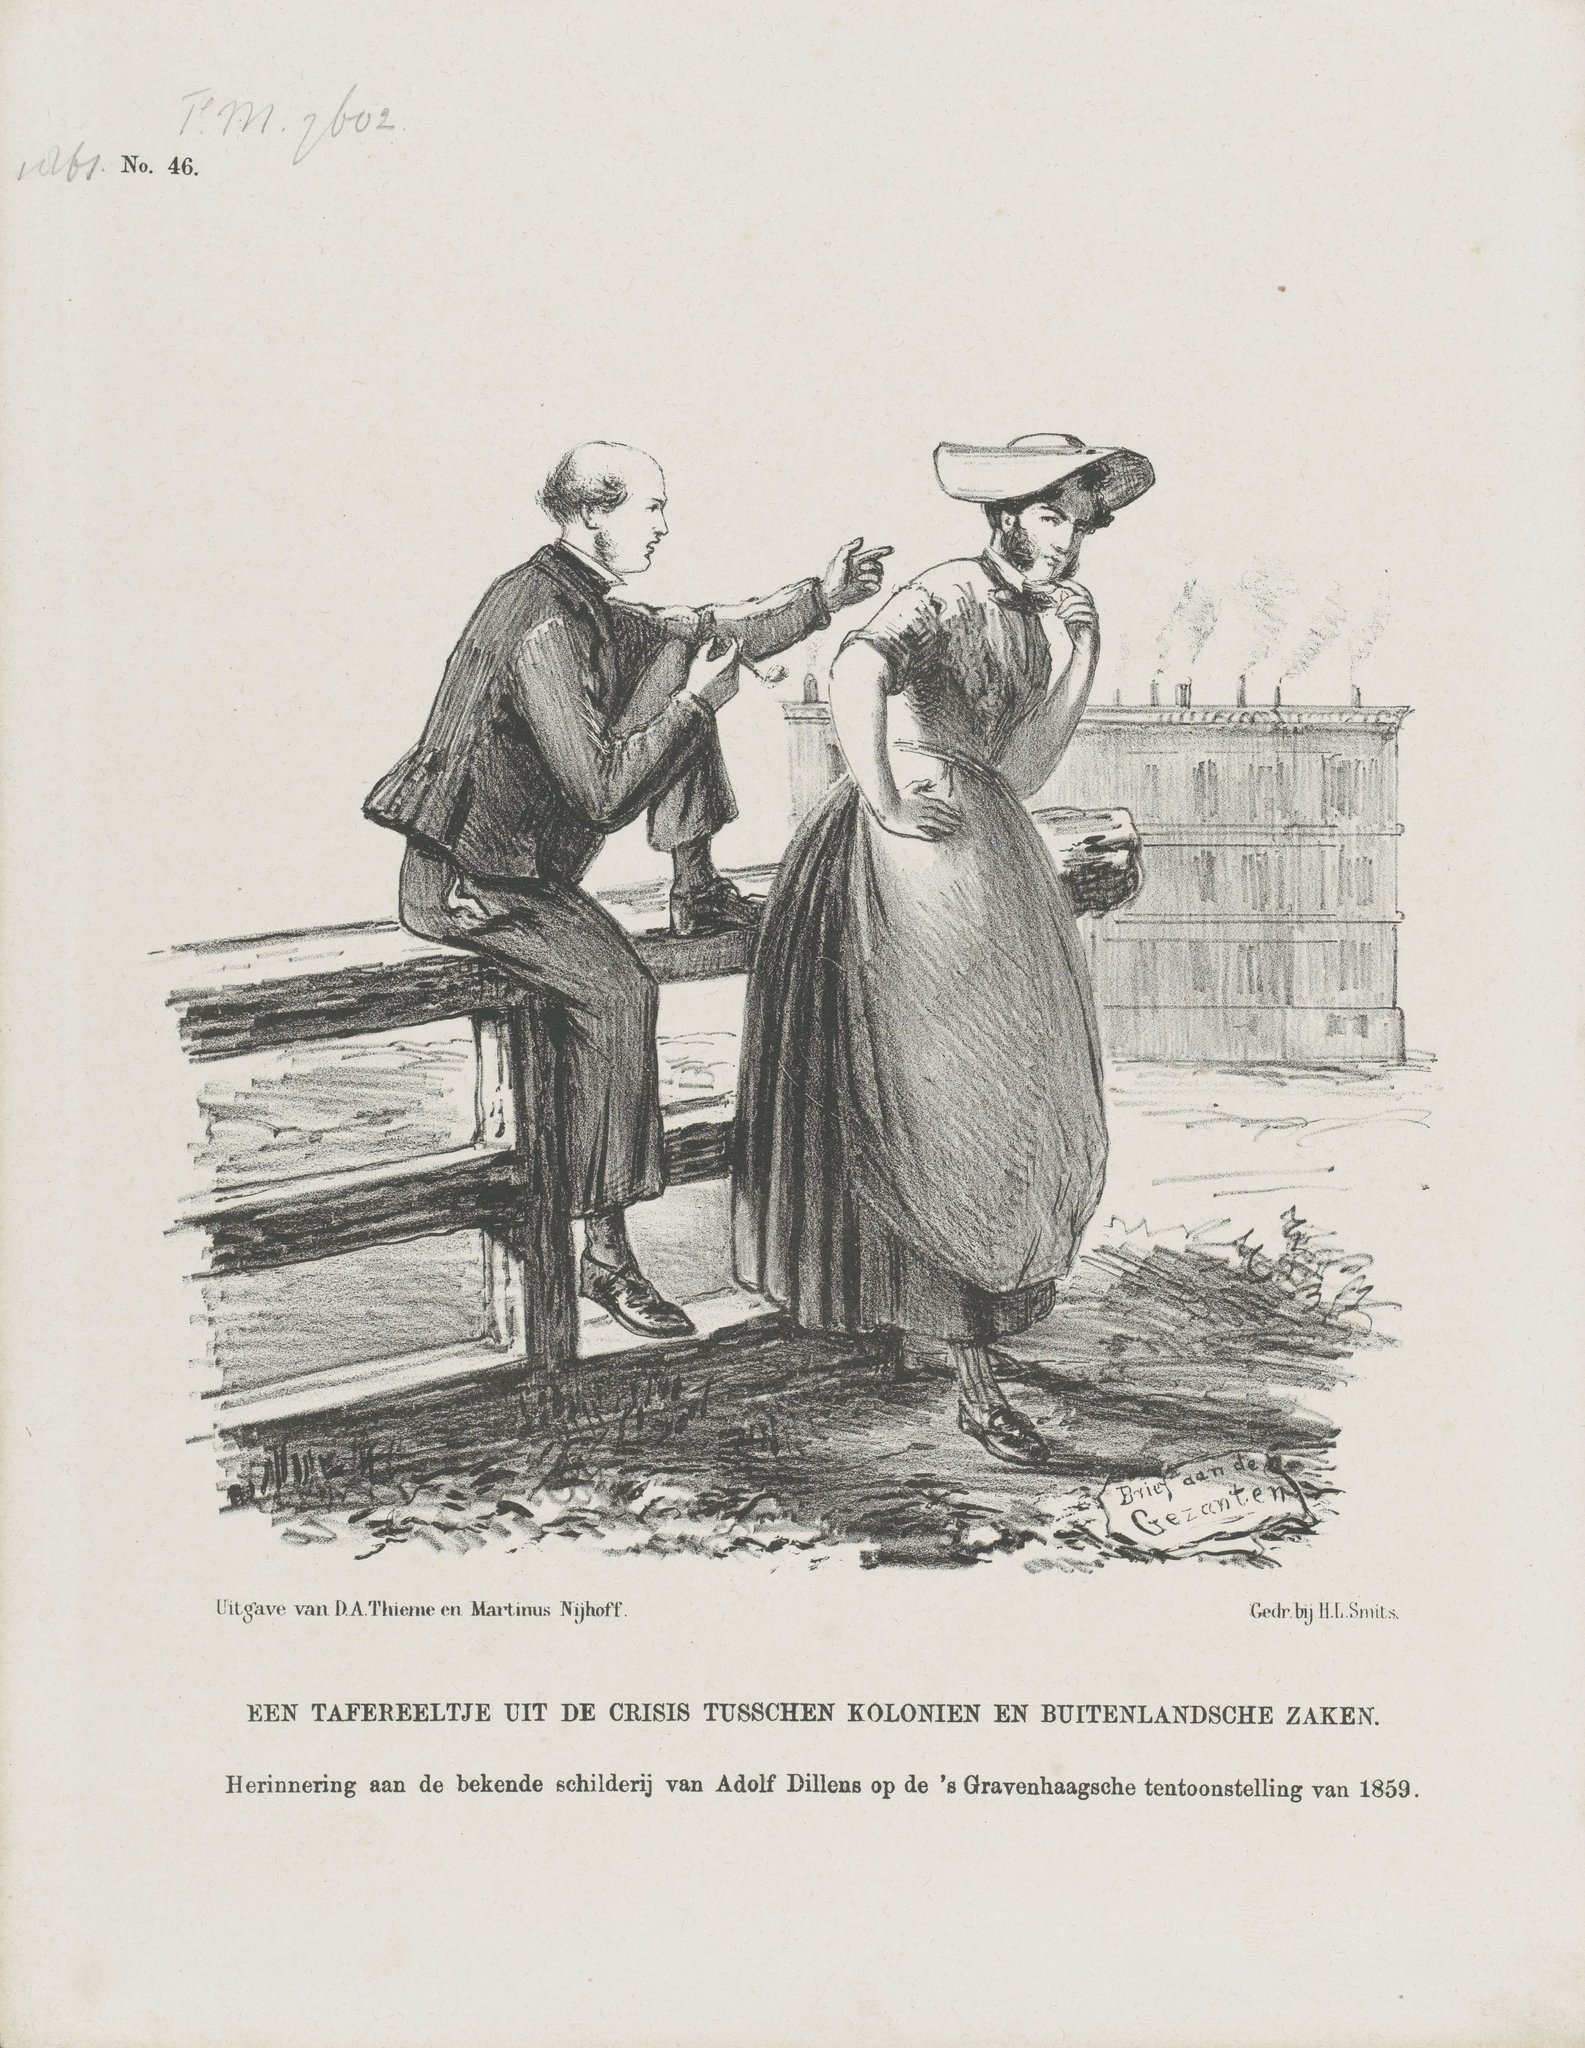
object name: print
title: Spotprent op de crisis tusen de ministers van Koloniën en Buitenlandse Zaken, 1861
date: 1861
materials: paper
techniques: lithograph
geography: netherlands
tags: james loudon, minister van buitenlandse zaken, kamerlid, jacob pieter pompejus van zuylen van nijevelt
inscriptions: collector's mark: Lugt 2228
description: Spotprent op de crisis tusen de Minister van Koloniën jhr. J. Loudon en de Minister van Buitenlandse Zaken baron van Zuylen. Voorgesteld als een gesprek tussen een Zeeuwse boer en boerin naar het bekende schilderij van Adolphe Dillens van 1859. Plaat verschenen bij het weekblad De Nederlandsche Spectator, nr. 46, 16 november 1861.